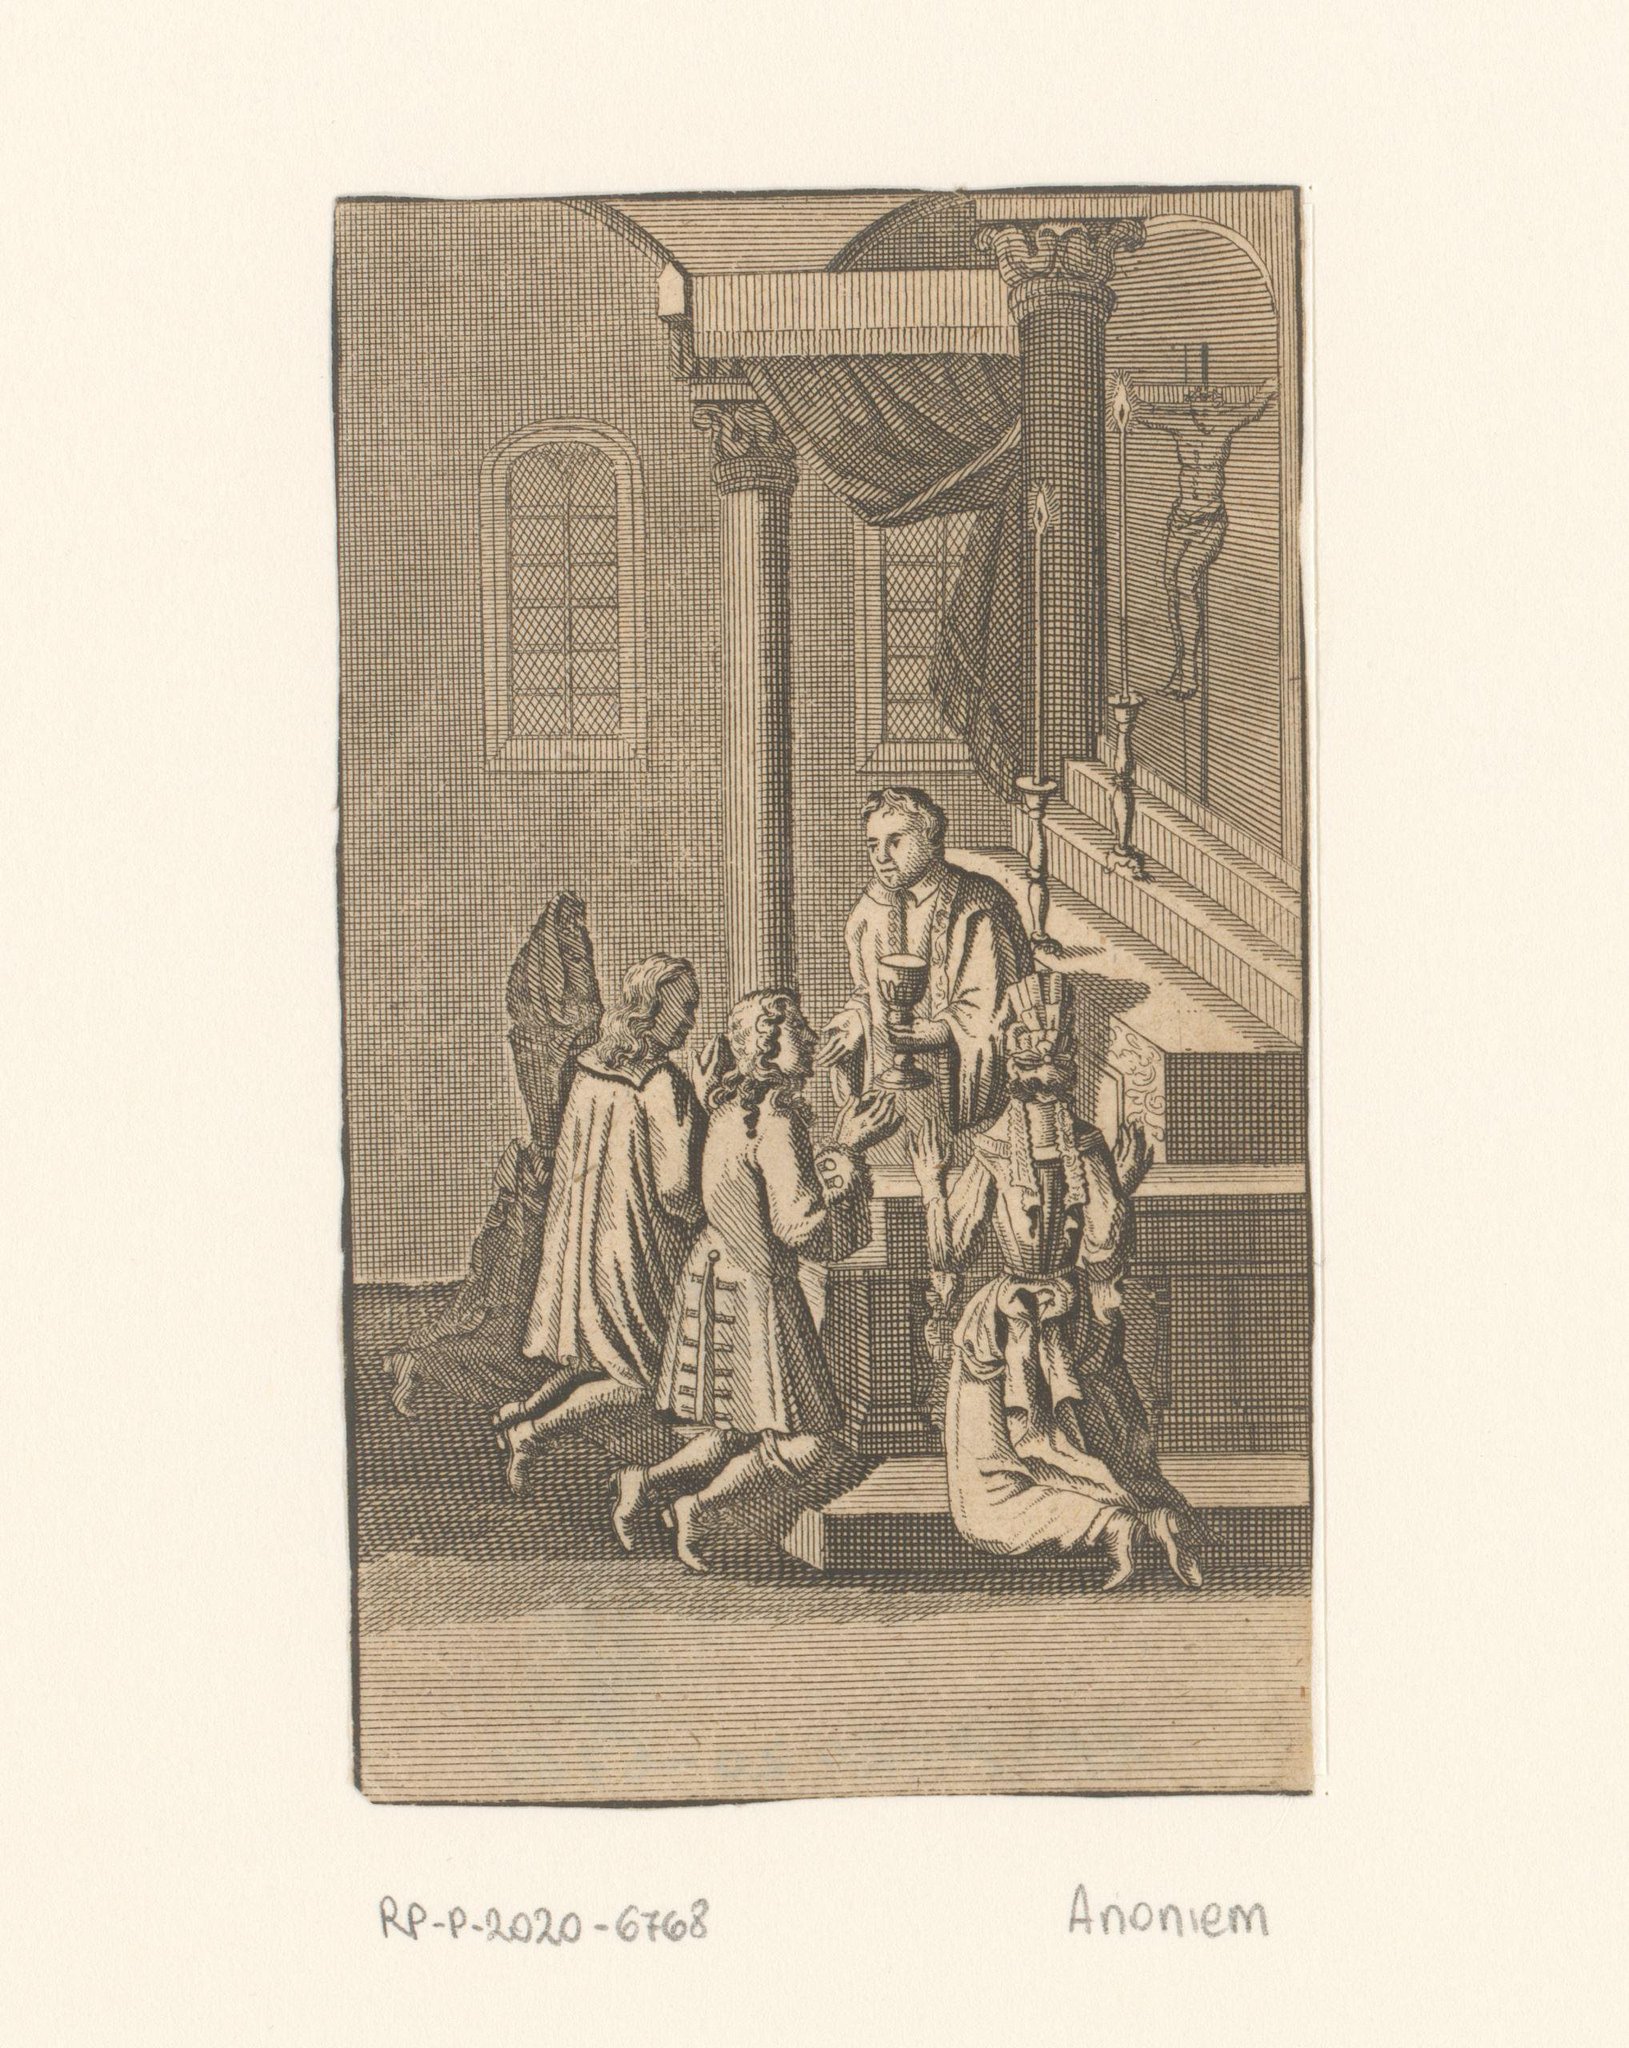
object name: print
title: Sacrament van de eucharistie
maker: Anonymous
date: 1700-1799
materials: paper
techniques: etching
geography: northern netherlands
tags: altarcross, crucifix, the eucharist ~ the fourth of the seven sacraments, interior of church, kneeling figure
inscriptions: collector's mark: Lugt 2228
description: Vier knielende mensen voor een priester. Een man ontvangt de hostie.